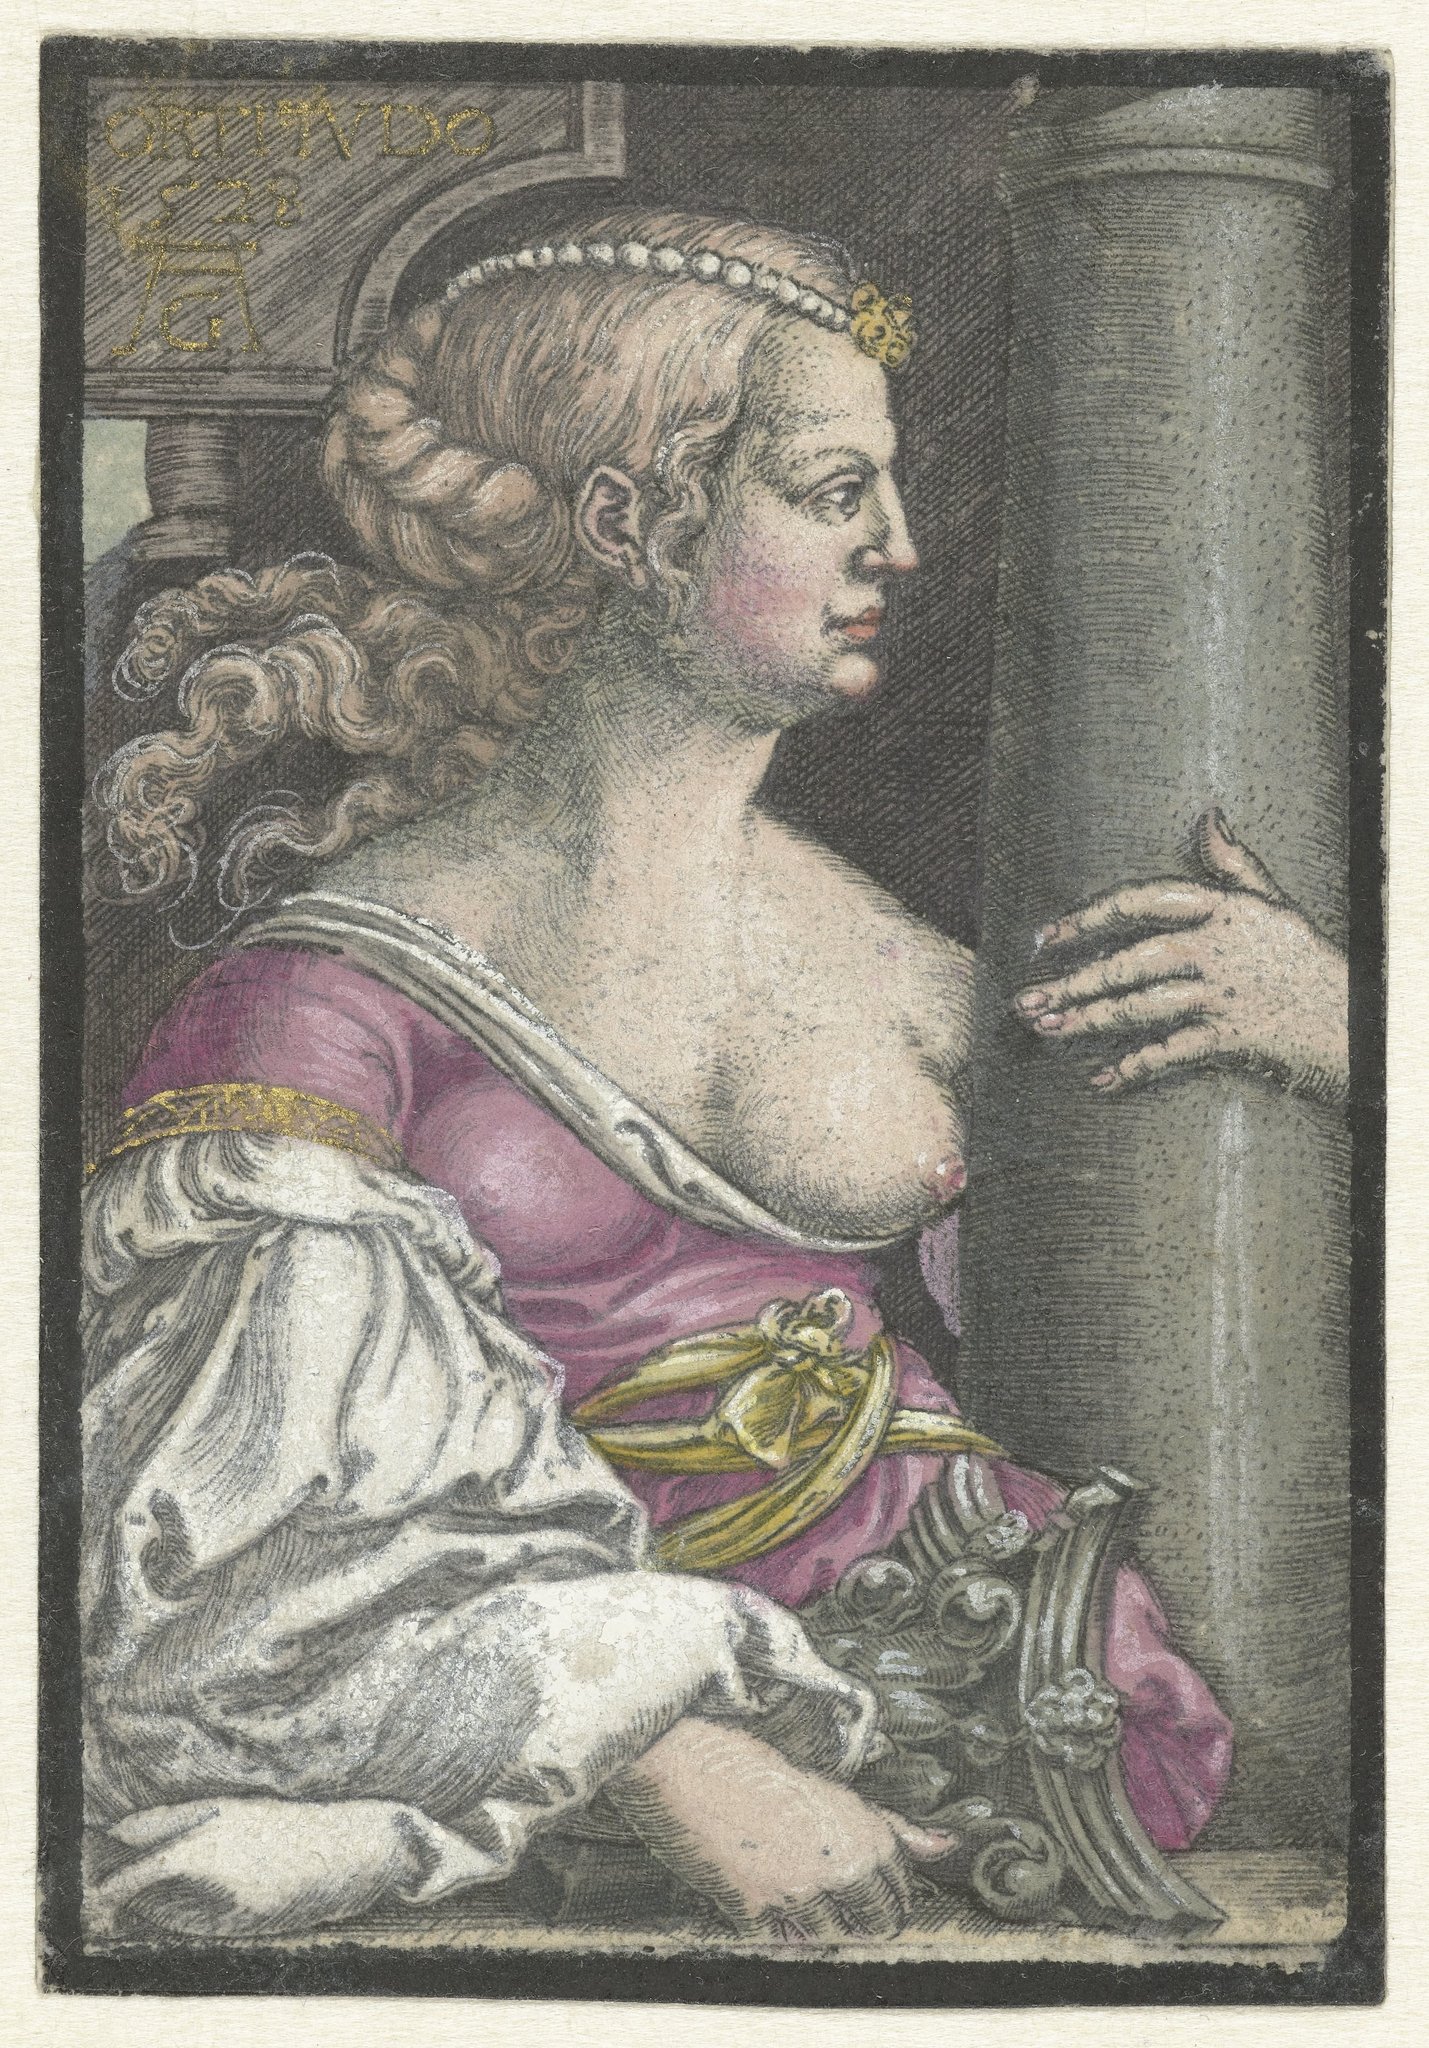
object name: print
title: Kracht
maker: heinrich aldegrever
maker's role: draughtsman, print maker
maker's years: 1502-1561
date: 1528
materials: paint, paper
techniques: engraving, hand coloring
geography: germany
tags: fortitude, 'fortitudo' ~ one of the four cardinal virtues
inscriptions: collector's mark: Lugt 2760, collector's mark: Lugt 2228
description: Vrouwelijke personificatie van Fortitudo, ten halven lijve. Zij is gekleed in een paarse jurk, die een van haar borsten ontbloot. Zij omvat een gebroken zuil, in haar andere hand het ornament van de zuil.